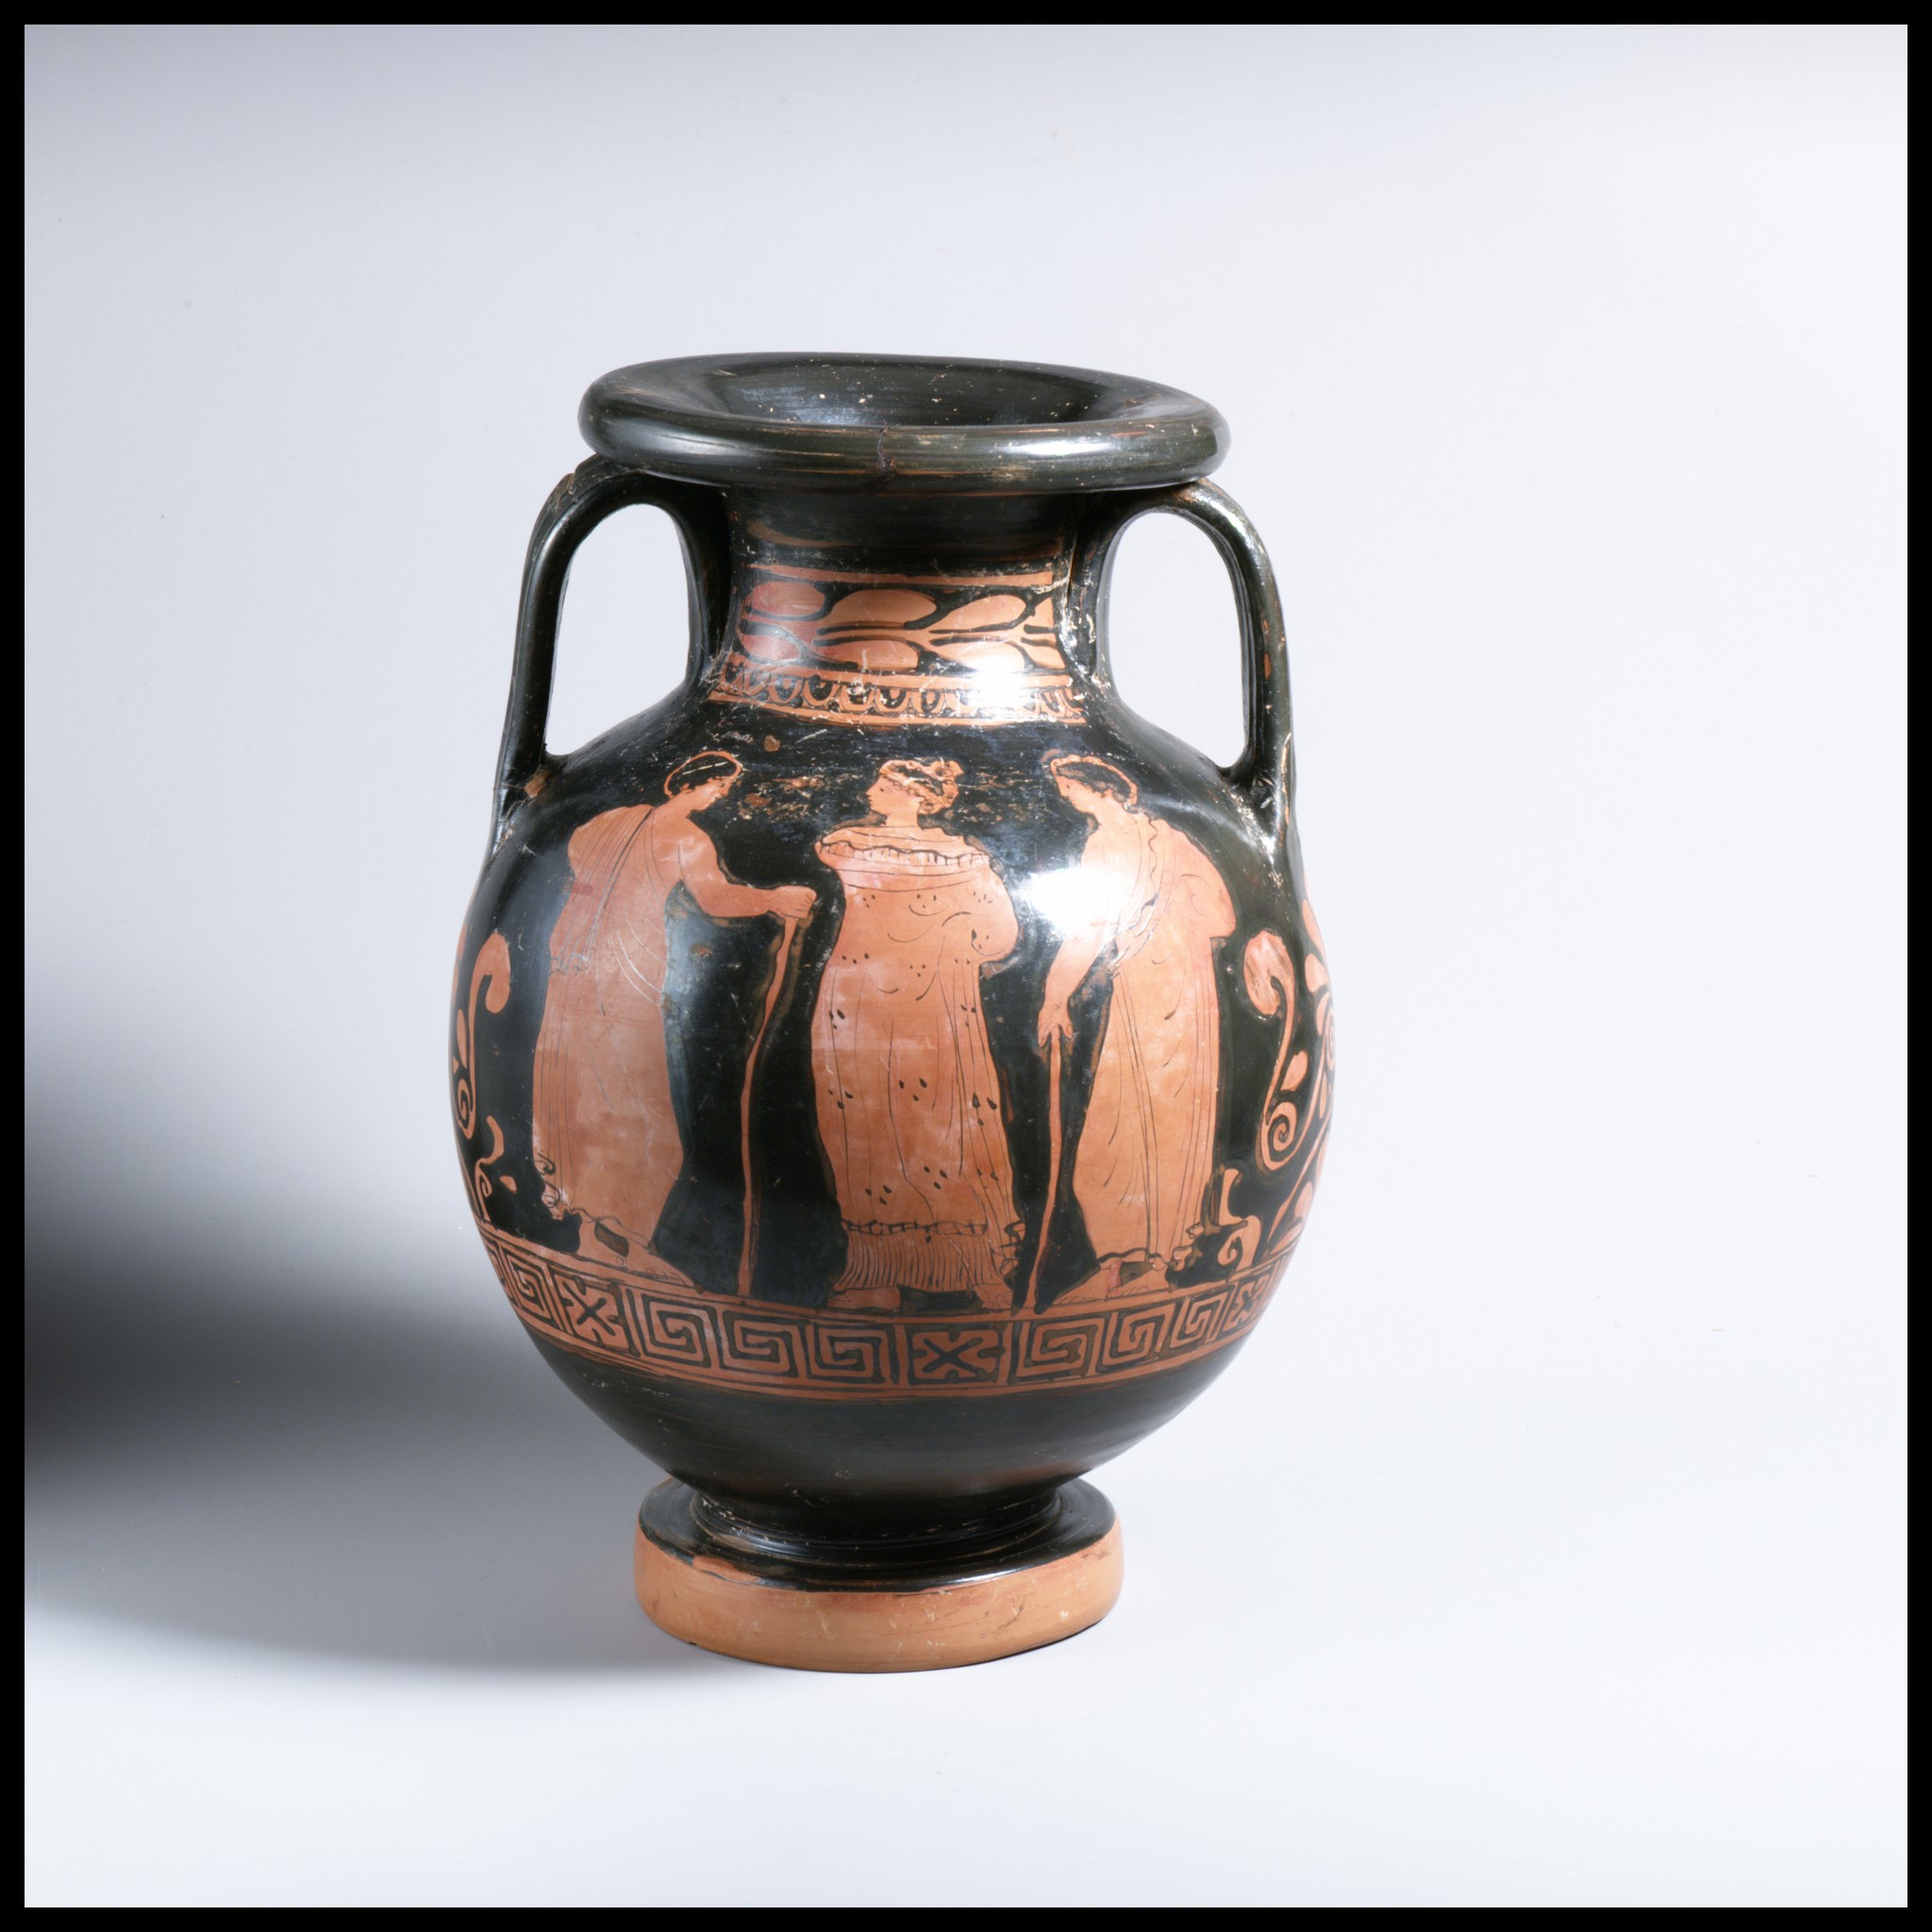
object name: pelike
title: Terracotta pelike (jar)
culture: greek, south italian, apulian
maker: dechter painter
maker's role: artist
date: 360-340 BCE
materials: terracotta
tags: eros,poseidon